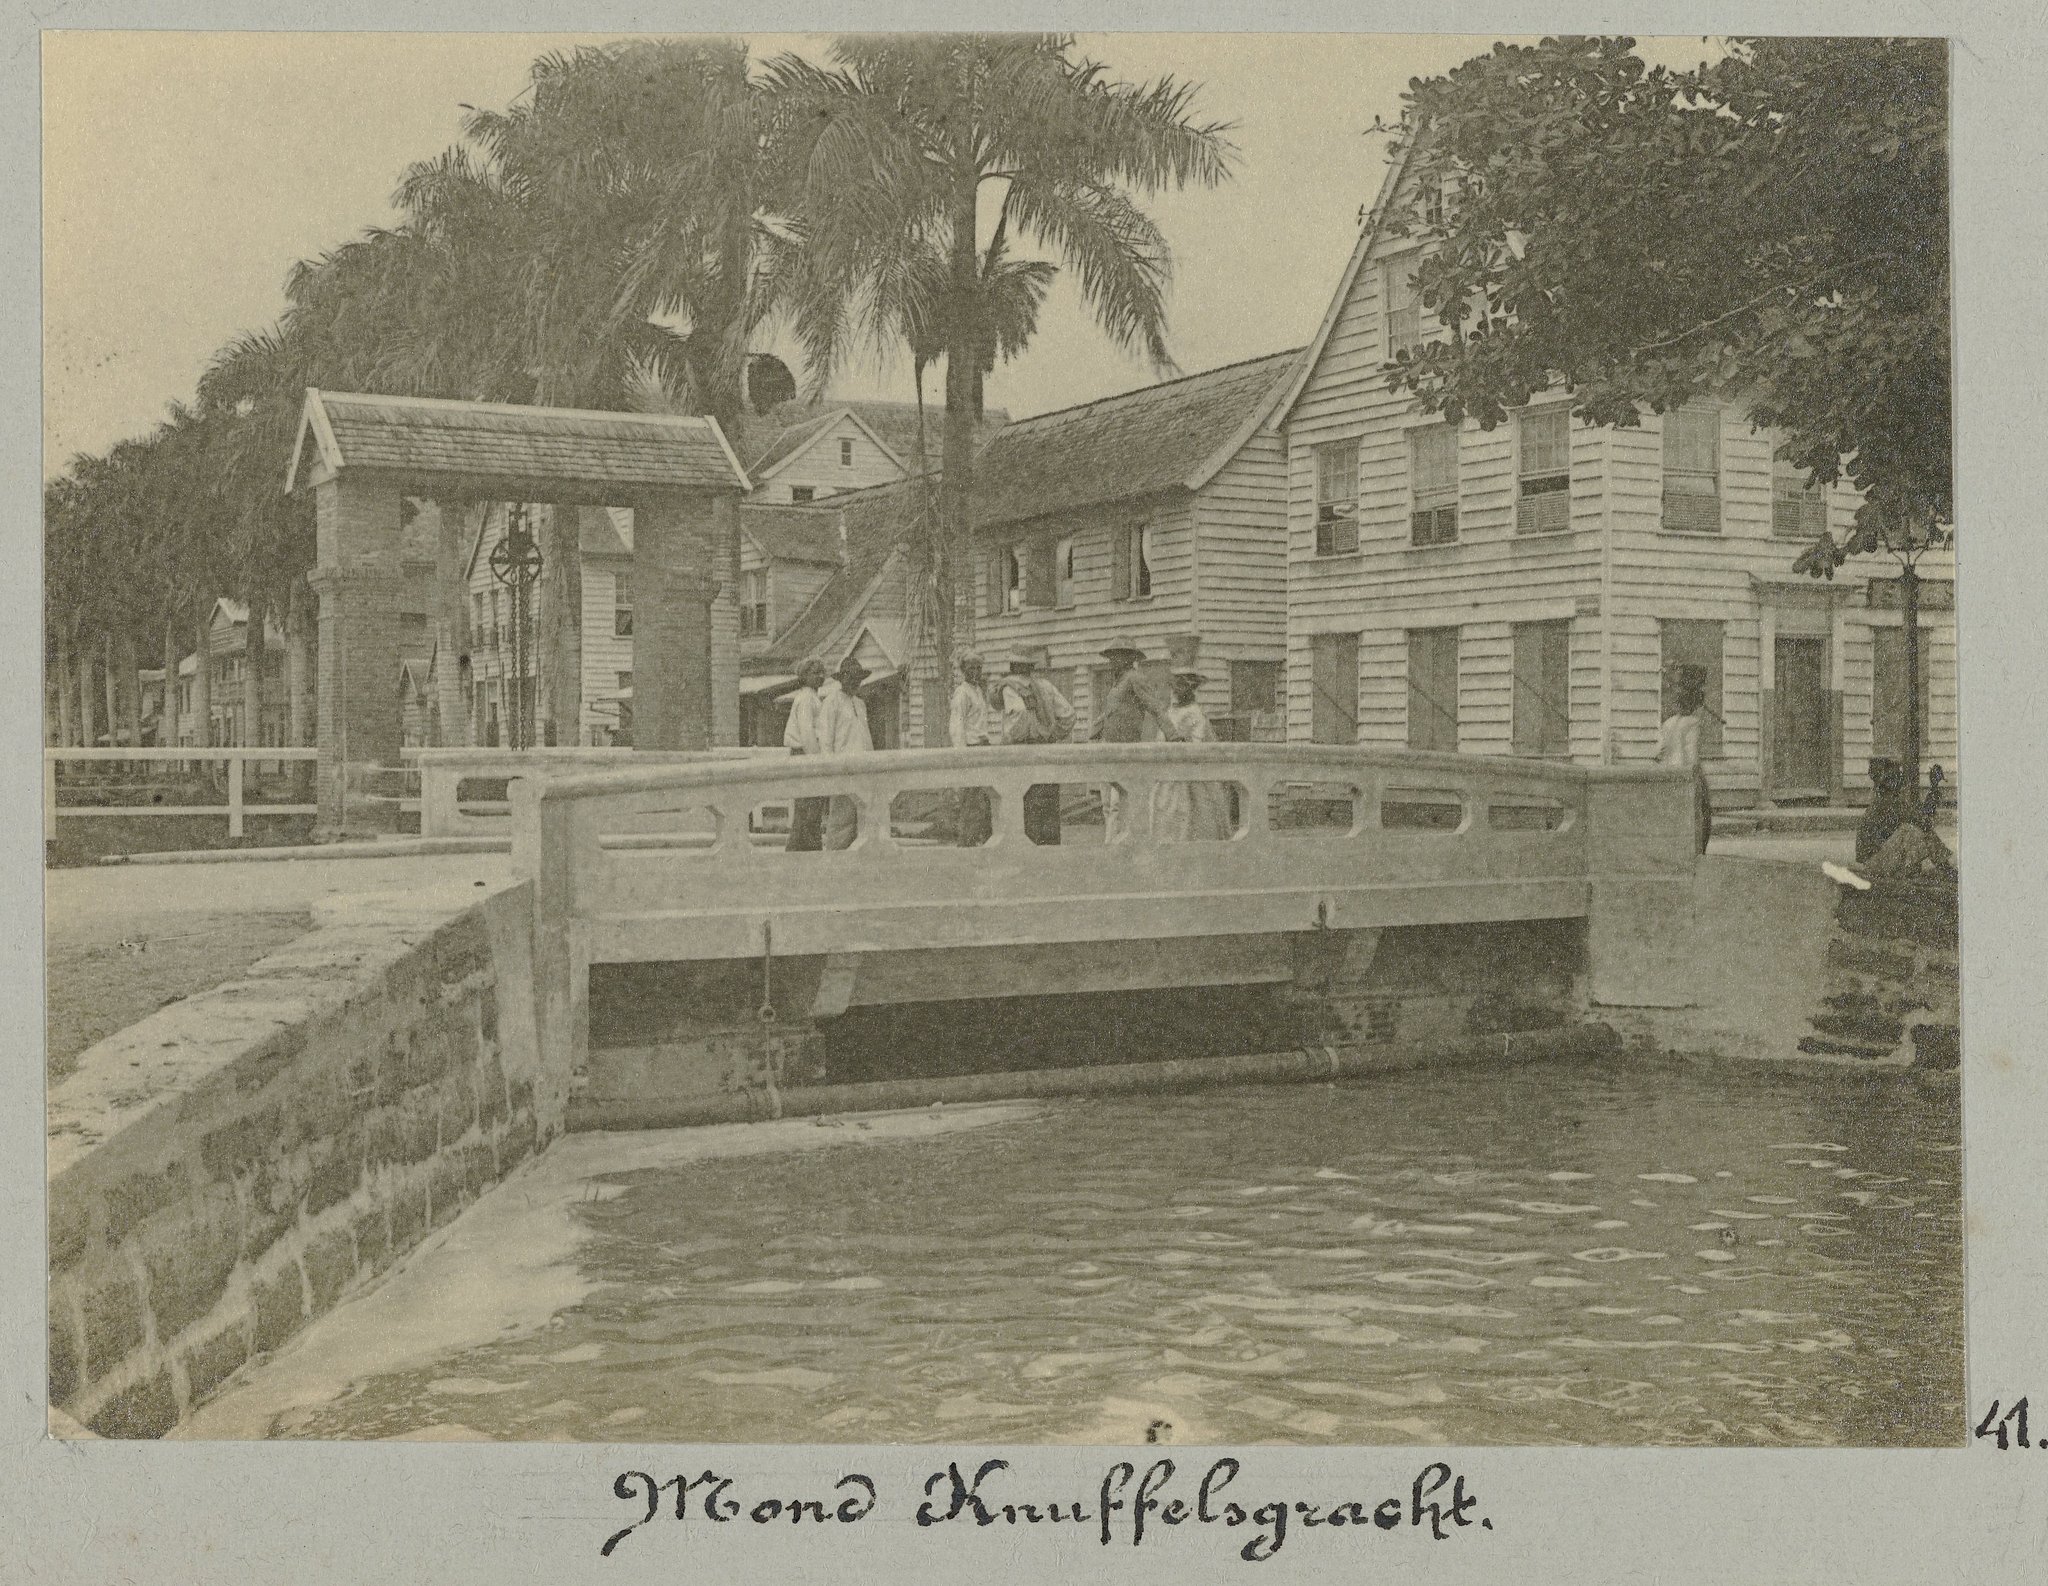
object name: photograph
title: Mond Knuffelsgracht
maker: hendrik doijer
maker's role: engineer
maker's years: 1863-1925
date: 1903-1910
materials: photographic support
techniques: gelatin silver print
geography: suriname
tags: suriname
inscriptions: inscription: ‘41. / Mond Knuffelsgracht.’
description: Brug aan het begin van de Knuffelsgracht te Paramaribo, op de brug staat een groepje personen. Onderdeel van het fotoalbum Souvenir de Voyage (deel 2), over het leven van de familie Doijer in en rond de plantage Ma Retraite in Suriname in de jaren 1903-1910.